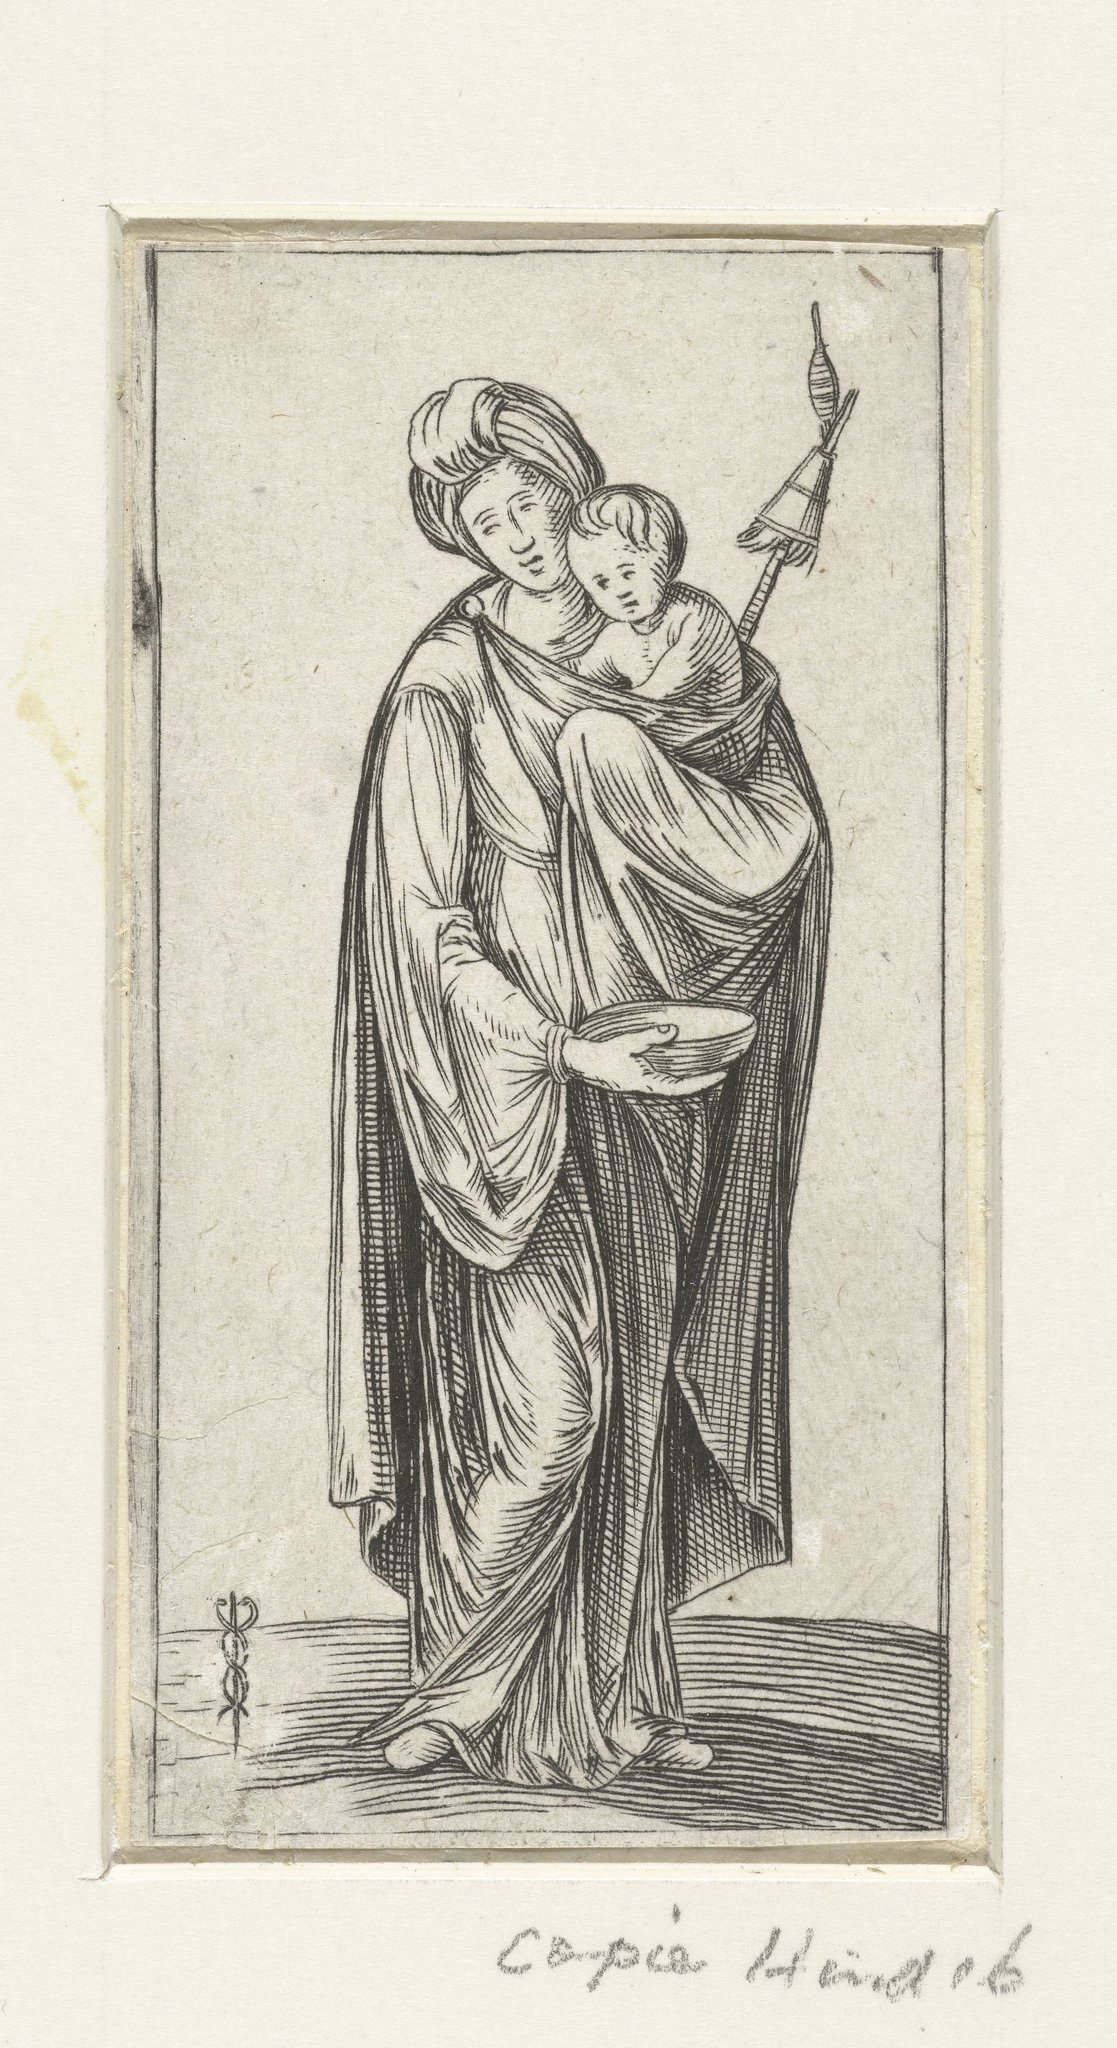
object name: print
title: Vrouw met kind en spinrokken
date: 1504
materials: paper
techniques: engraving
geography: italy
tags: distaff, mother and baby or young child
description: Kopie naar prent van Jacopo de' Barbari.